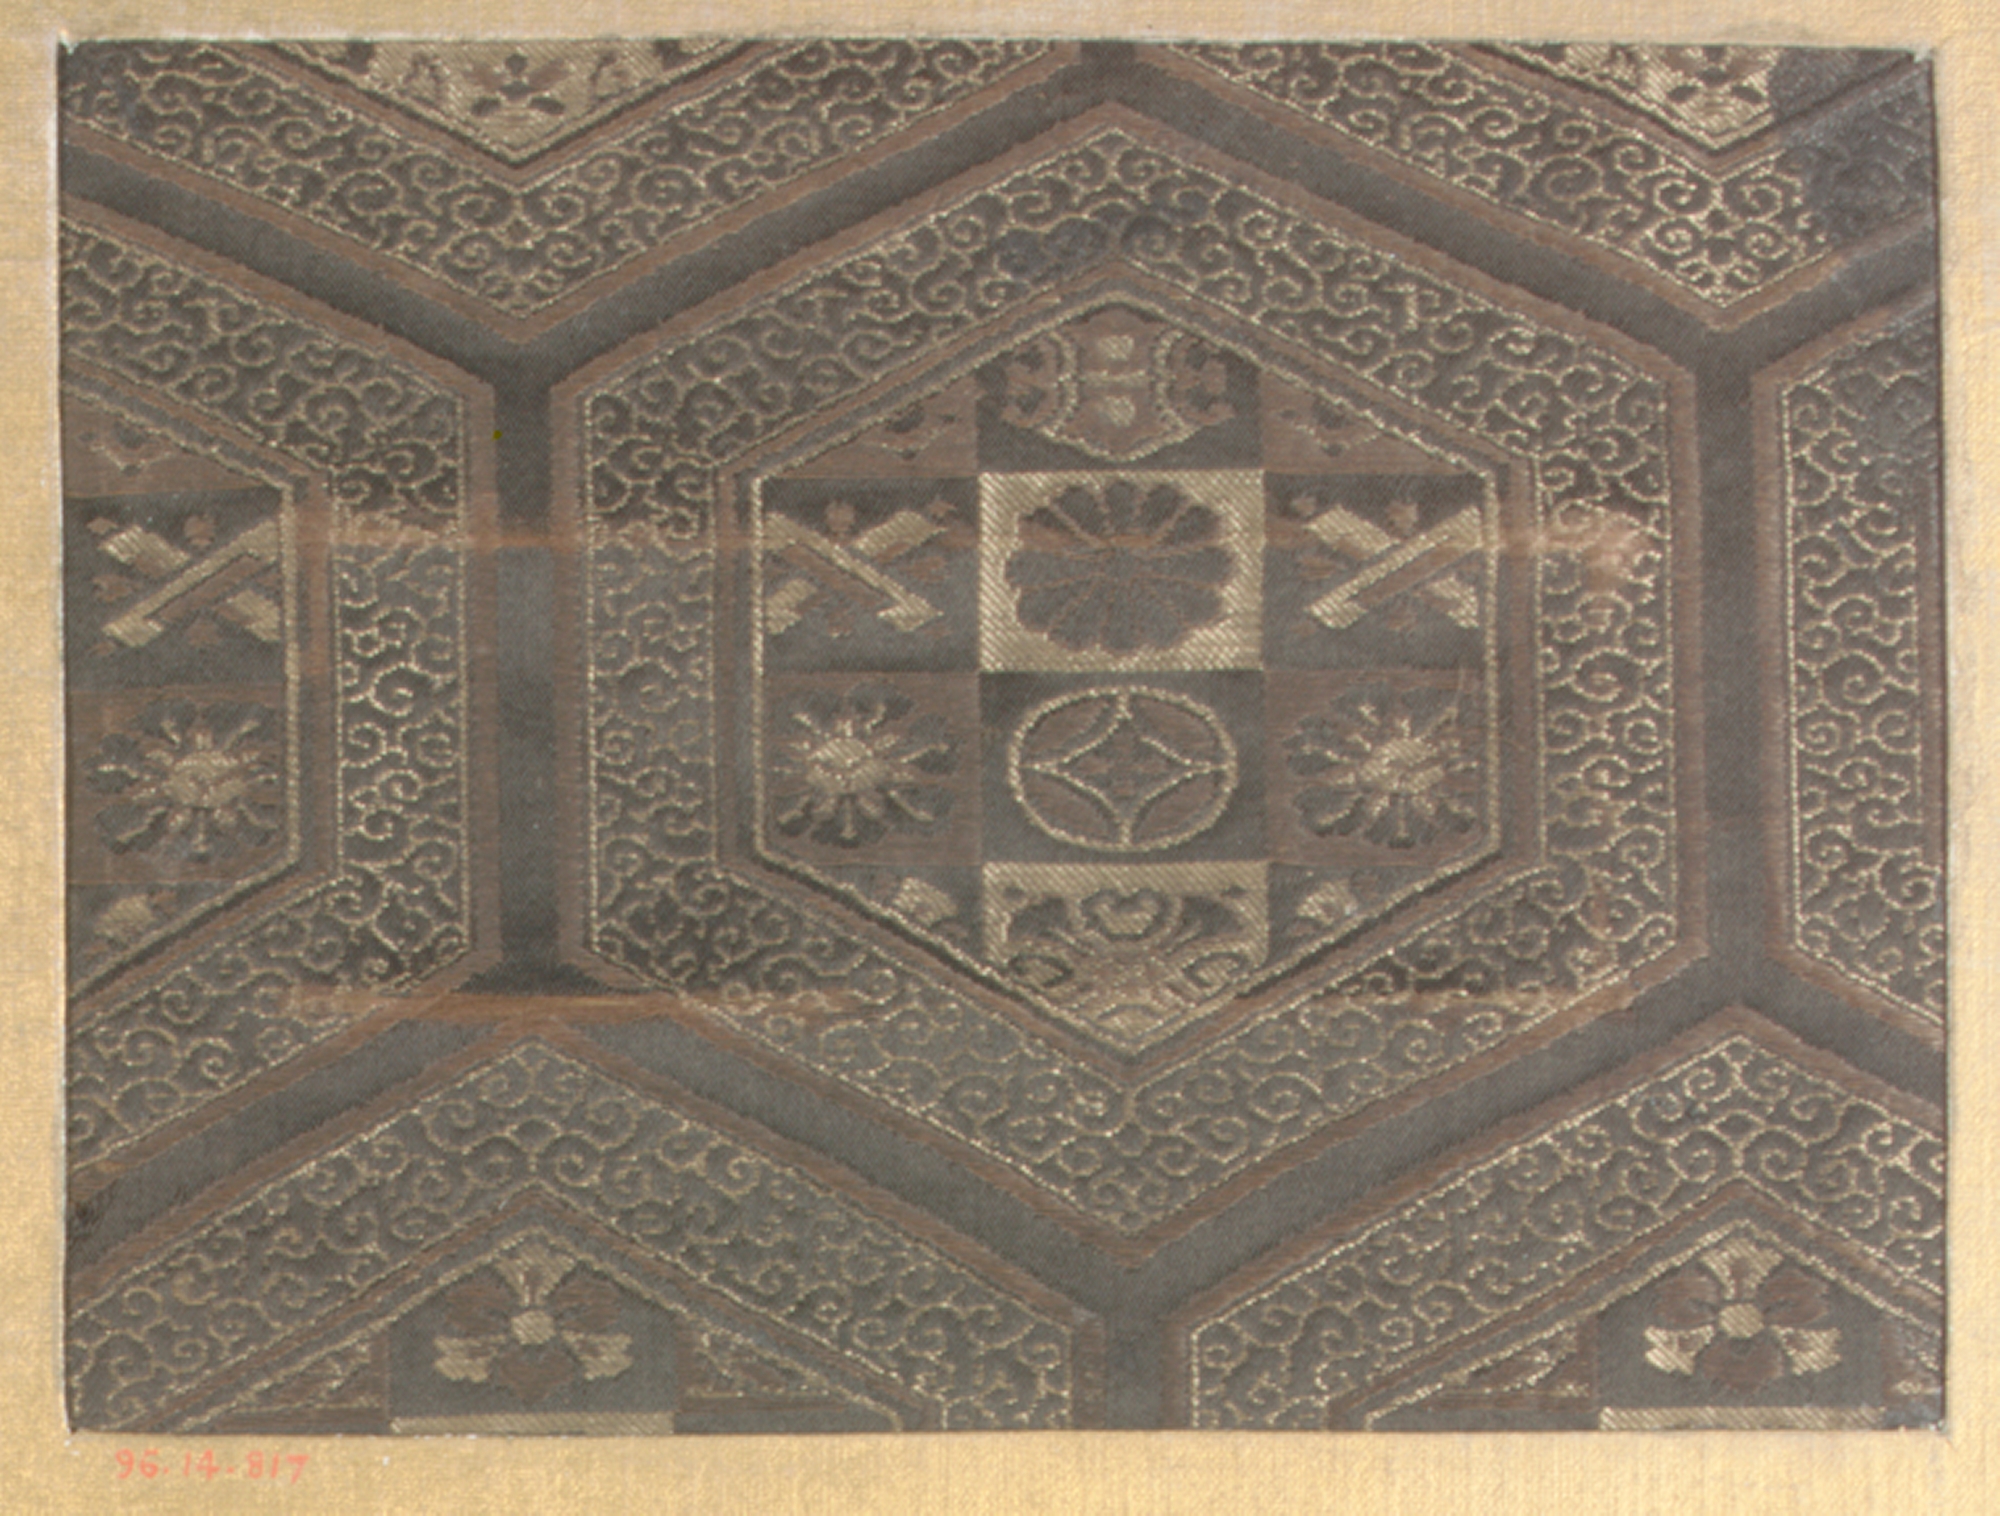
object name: piece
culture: japanese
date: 1701-1900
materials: silk